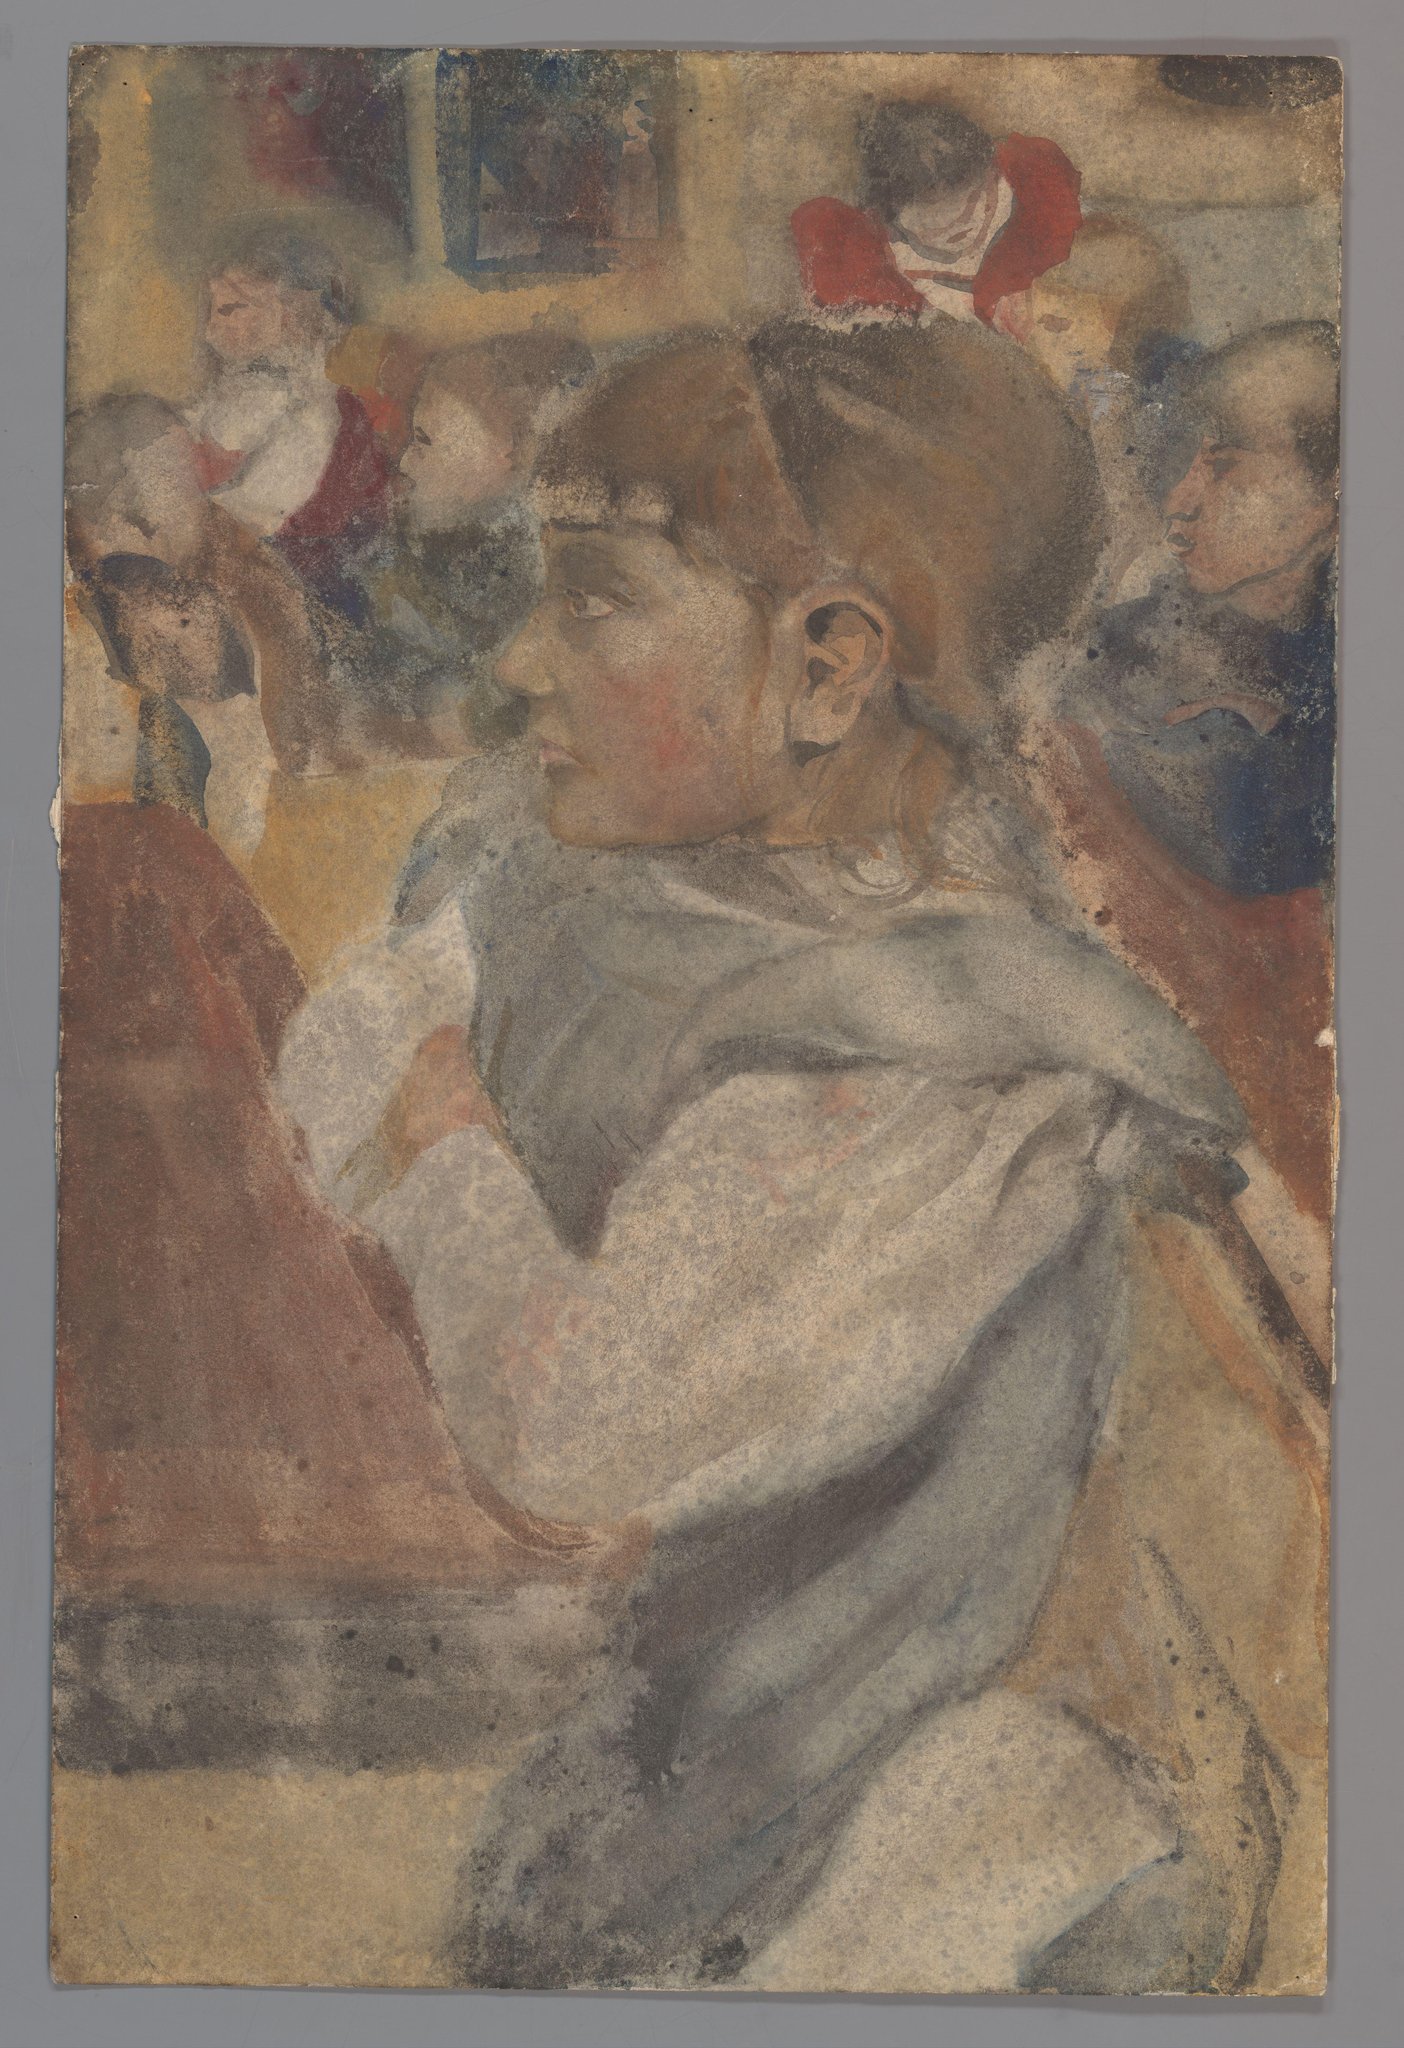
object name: drawing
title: Zittend meisje achter schoolbank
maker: carel adolph lion cachet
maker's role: draughtsman, print maker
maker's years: 1864-1945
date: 1874-1945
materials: paper, watercolor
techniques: brush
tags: elementary school; class, form